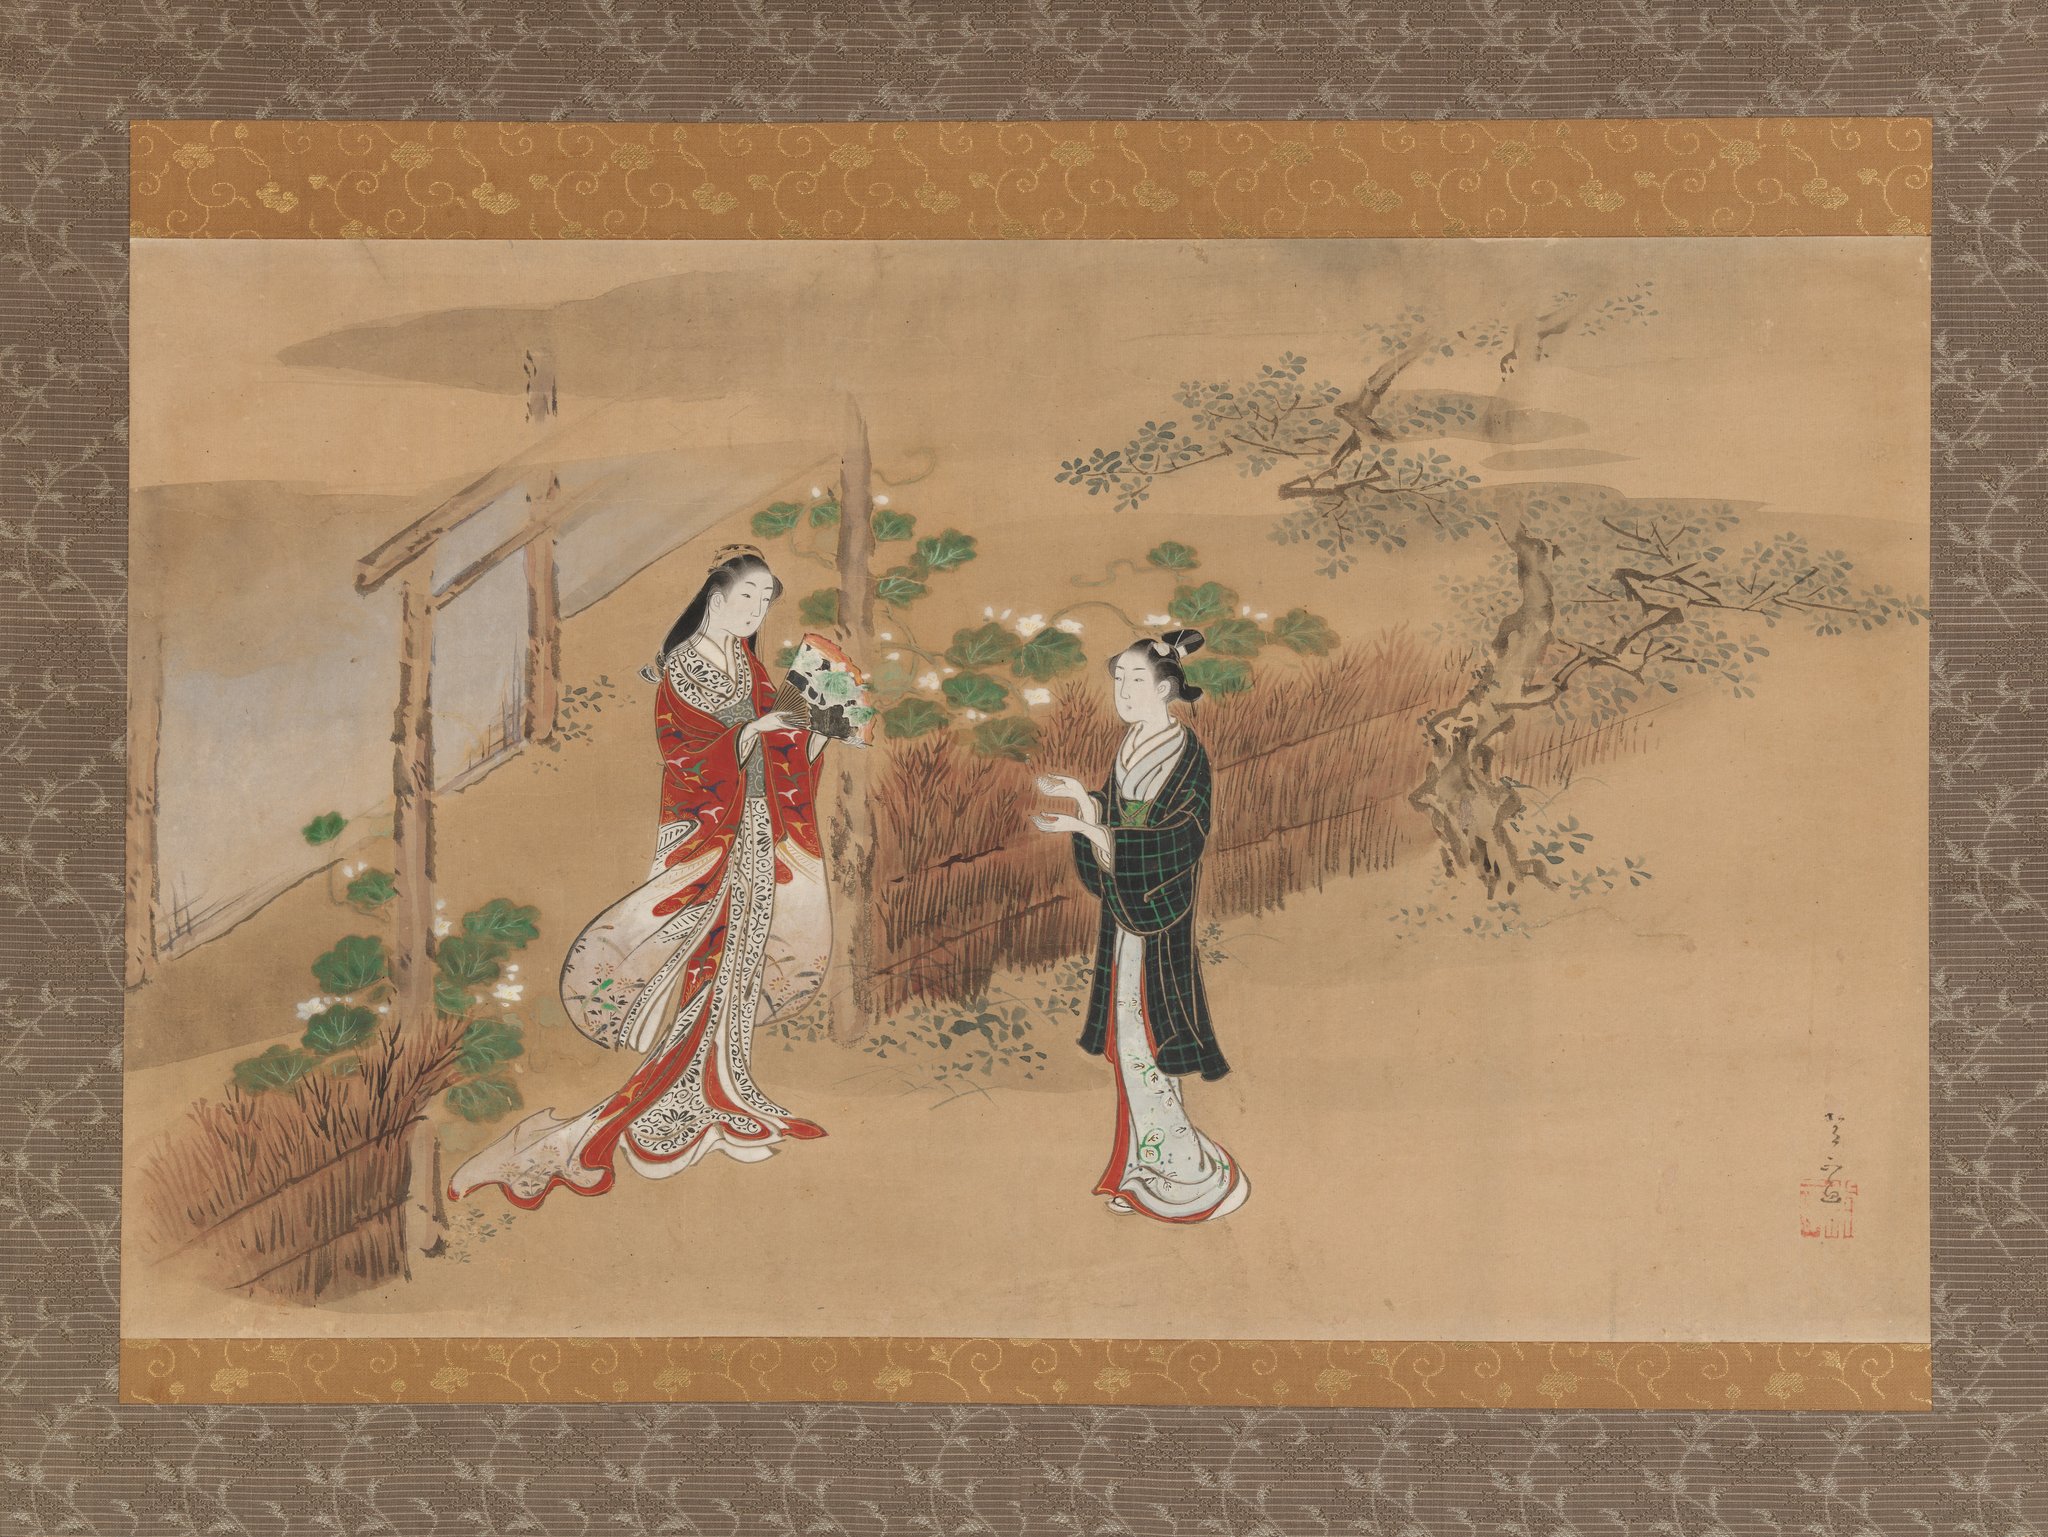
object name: hanging scroll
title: "Evening Faces" chapter from The Tale of Genji (Genji monogatari)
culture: japanese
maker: kawamata tsunemasa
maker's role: artist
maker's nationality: japanese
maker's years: 1706-1758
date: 1701-1800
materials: ink, paper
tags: women